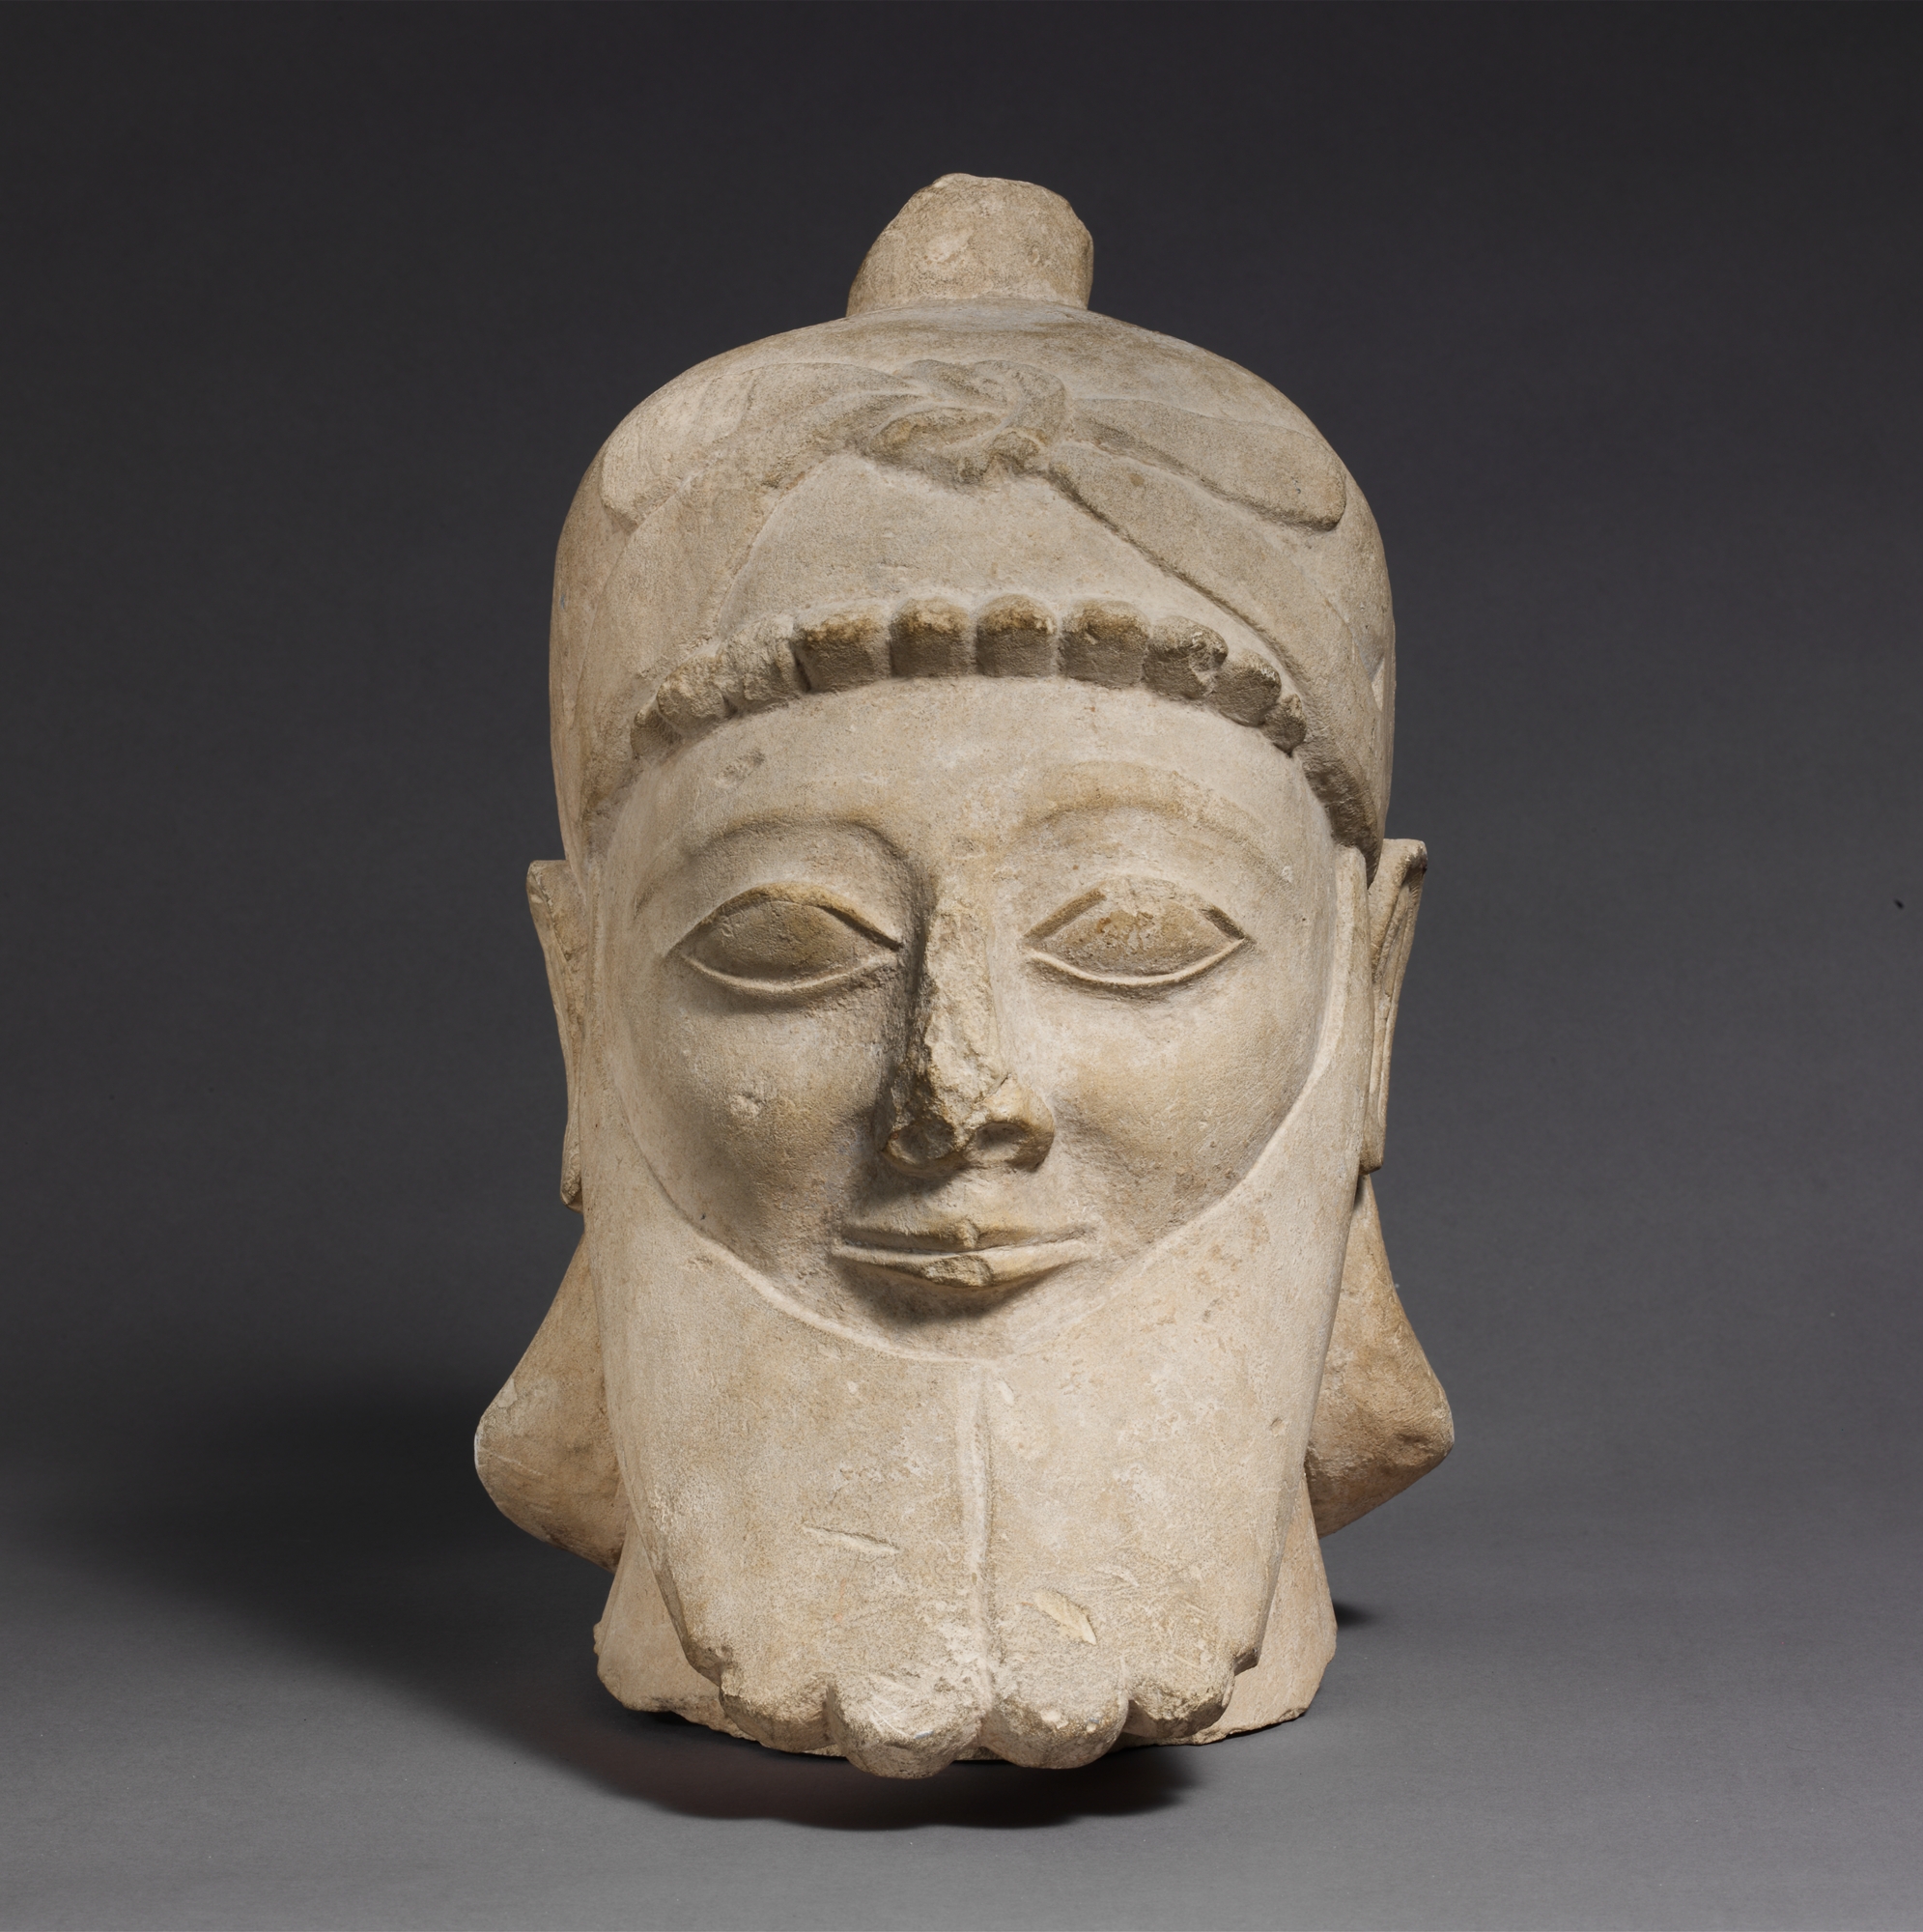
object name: head of a warrior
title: Limestone head of a bearded male wearing a conical helmet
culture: cypriot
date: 600-551 BCE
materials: limestone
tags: helmets,heads,men